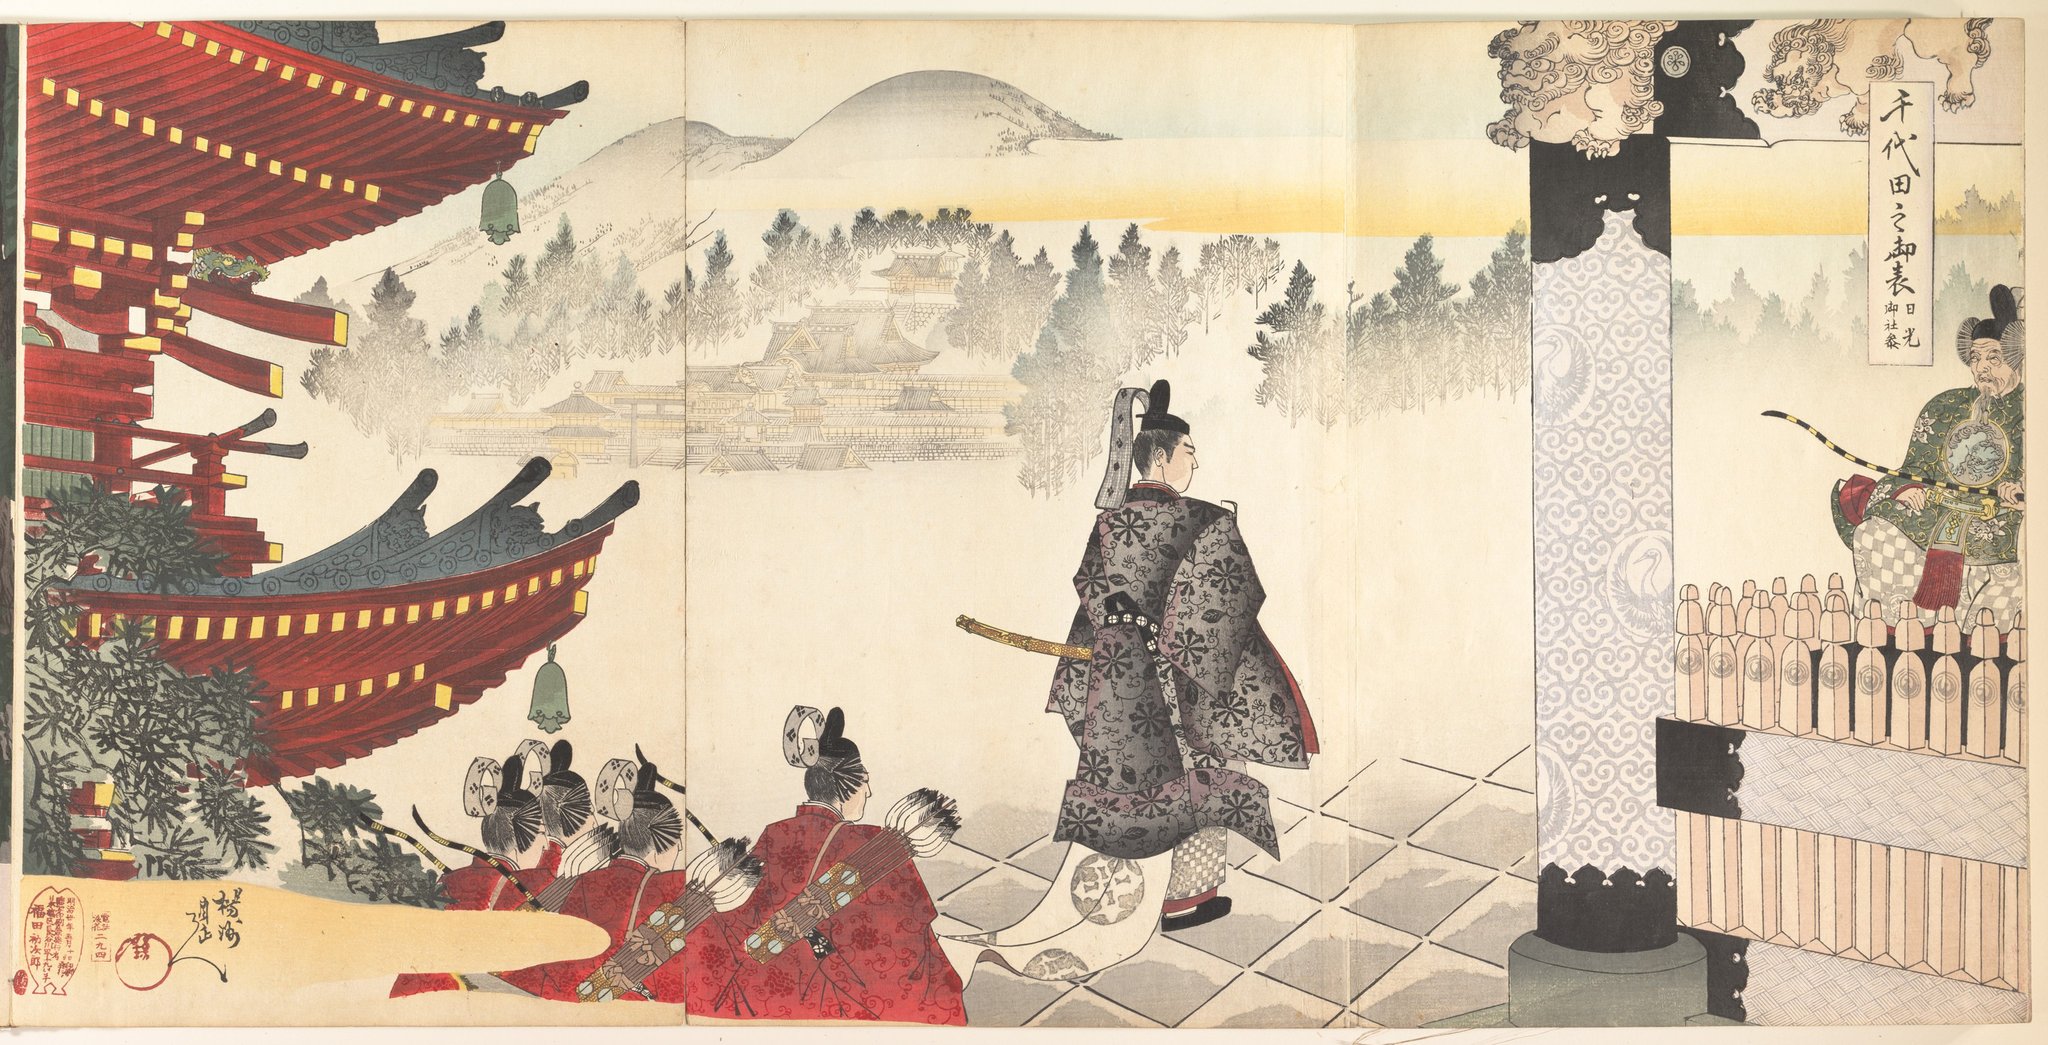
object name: print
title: Chiyoda Castle (Album of Men)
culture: japanese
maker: yōshū (hashimoto) chikanobu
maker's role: artist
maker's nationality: japanese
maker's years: 1838-1912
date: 1897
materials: ink, paper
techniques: woodblock print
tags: castles,bow and arrow,men,mountains,trees